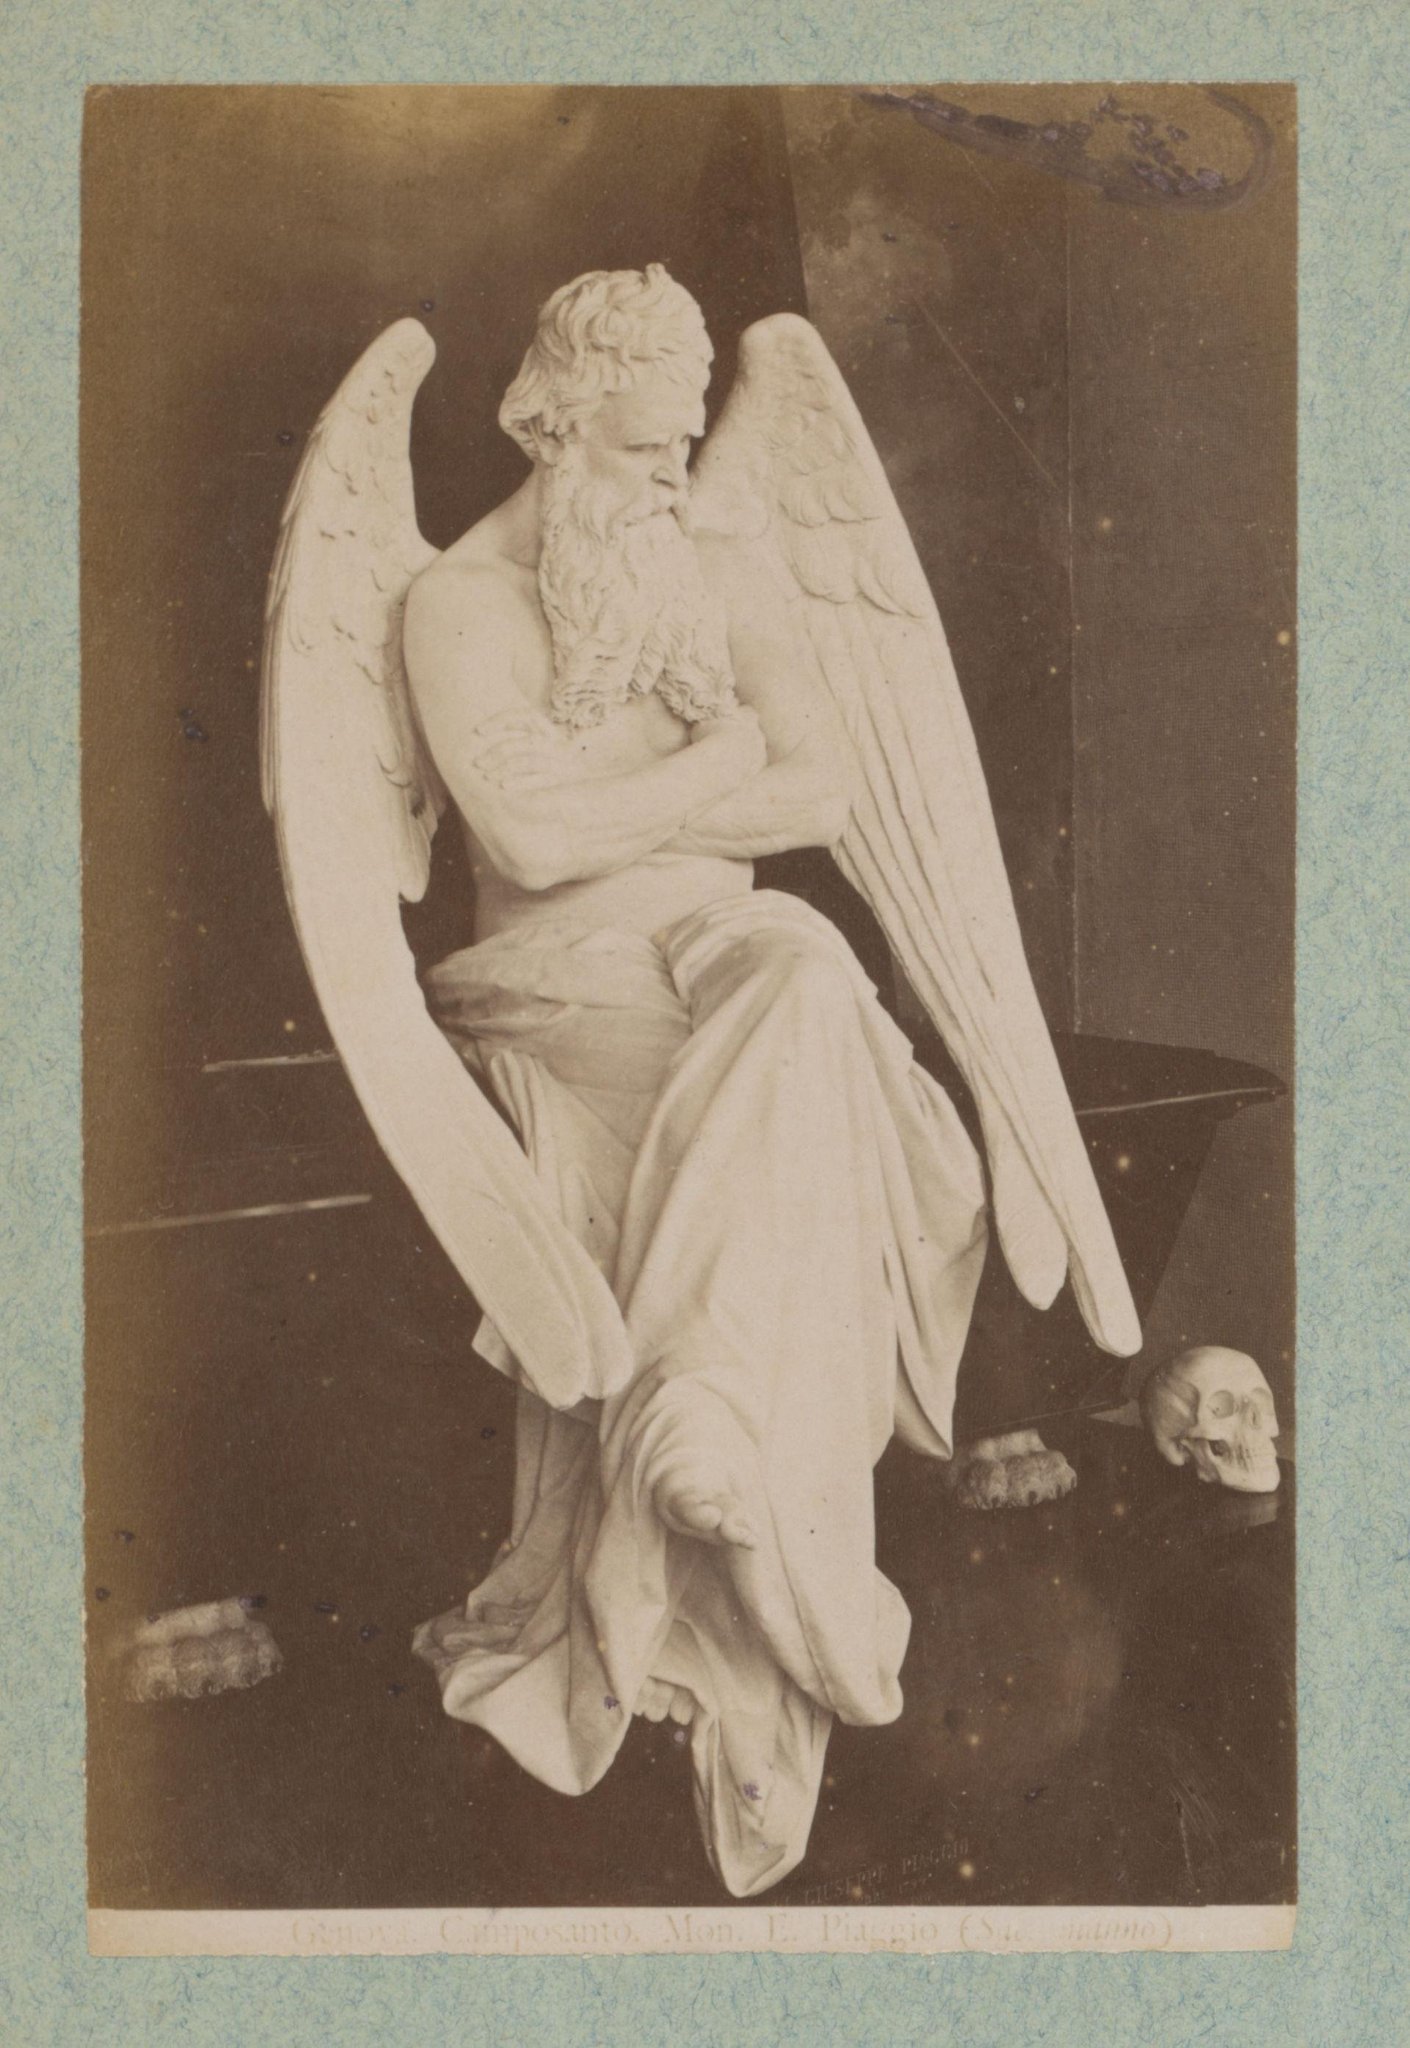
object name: photograph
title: Grafmonument voor E. Piaggio naar Santo Saccomanno op de begraafplaats van Staglieno te Genua, Italië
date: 1876-1890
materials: cardboard, paper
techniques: albumen print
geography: genoa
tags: sculpture, grave-building, monumental tomb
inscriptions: collector's mark: ‘VOSMAER’